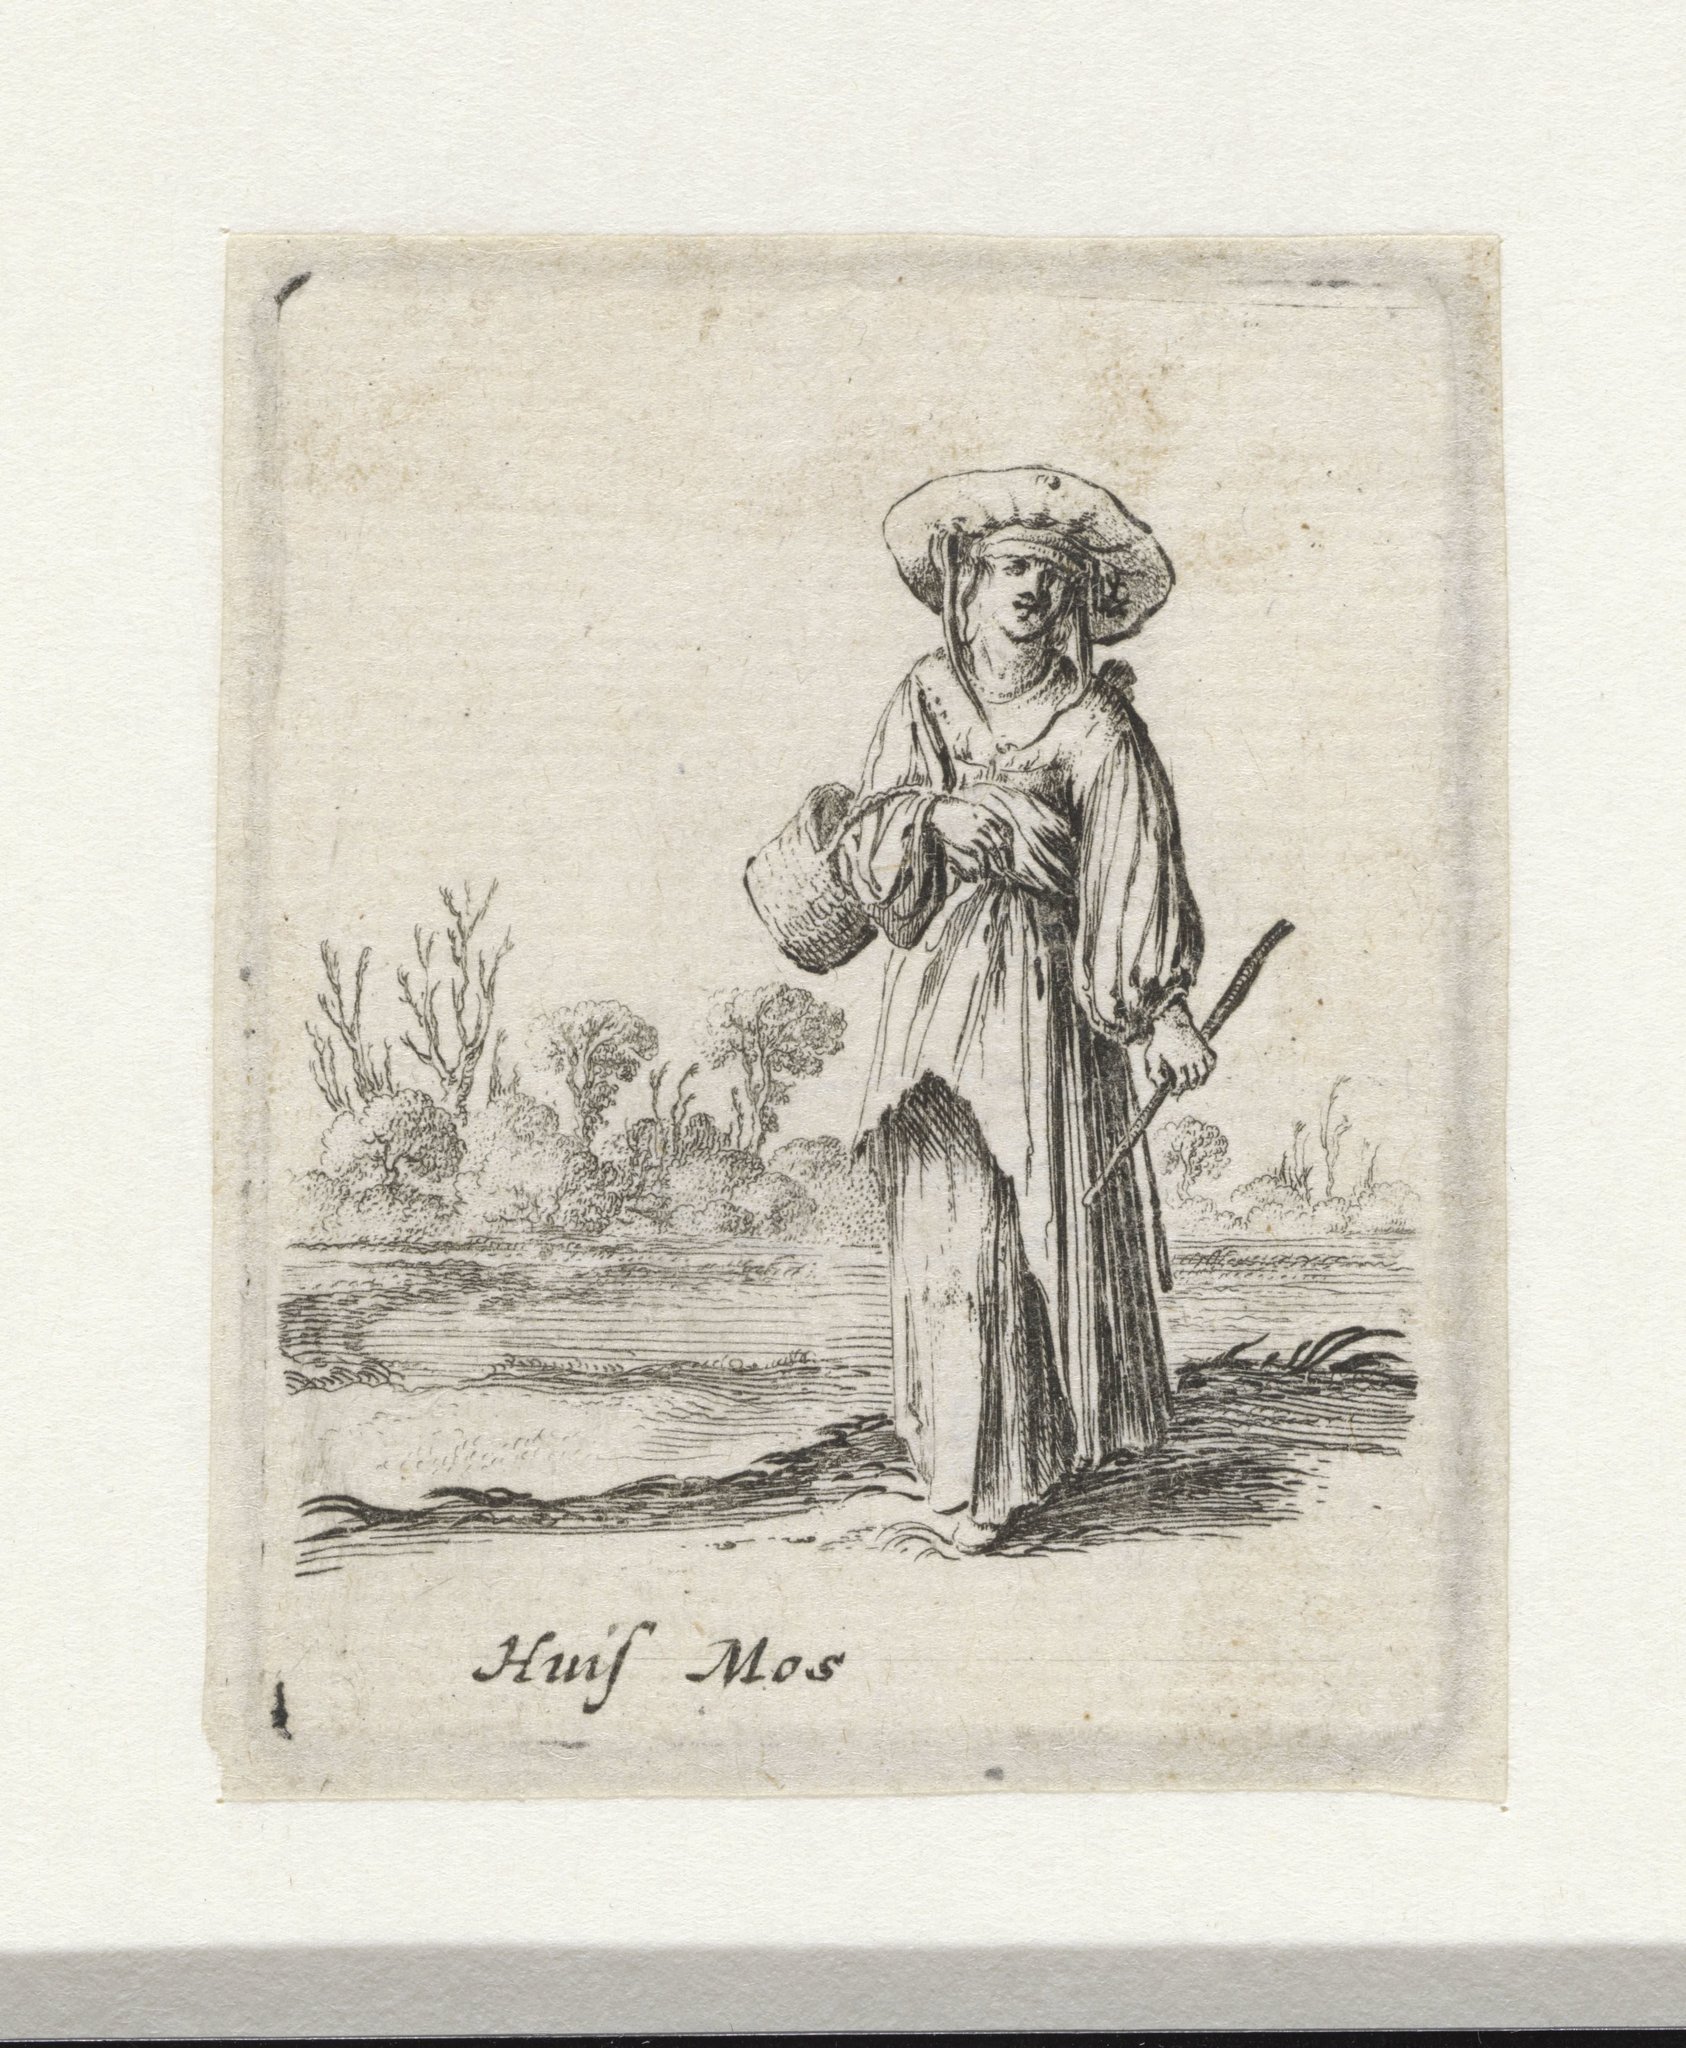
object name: print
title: Huis Mos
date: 1638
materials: paper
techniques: engraving, etching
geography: amsterdam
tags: carrying something in basket, bag, rucksack, etc.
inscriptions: collector's mark: Lugt 2228, collector's mark: Lugt 2760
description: Bij een rivier staat een vrouw met op het hoofd een hoed en om de arm een mand. De prent maakt deel uit van een serie van 32 prenten met genretaferelen.